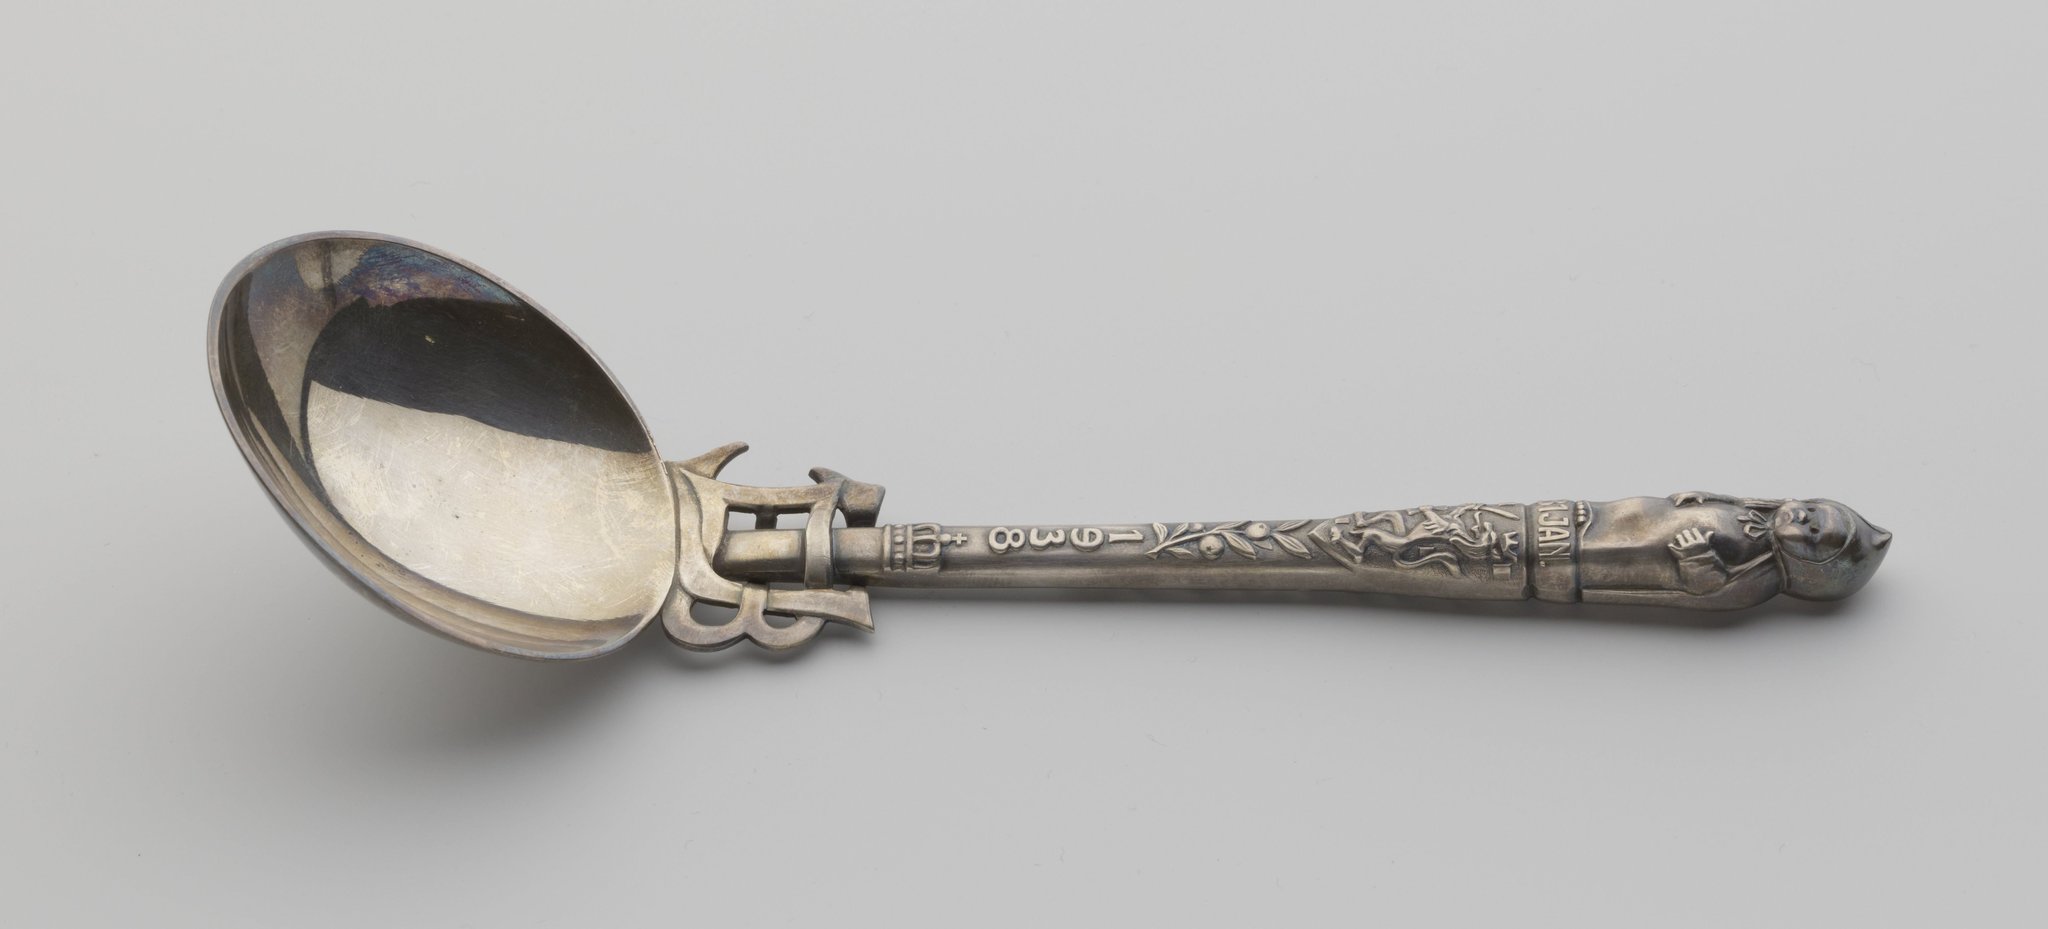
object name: birth spoon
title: Geboortelepel versierd op de steel en voorzien van een monogram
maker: gerrit jan van der veen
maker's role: sculptor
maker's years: 1902-1944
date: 1938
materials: alloy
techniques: silvering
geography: netherlands